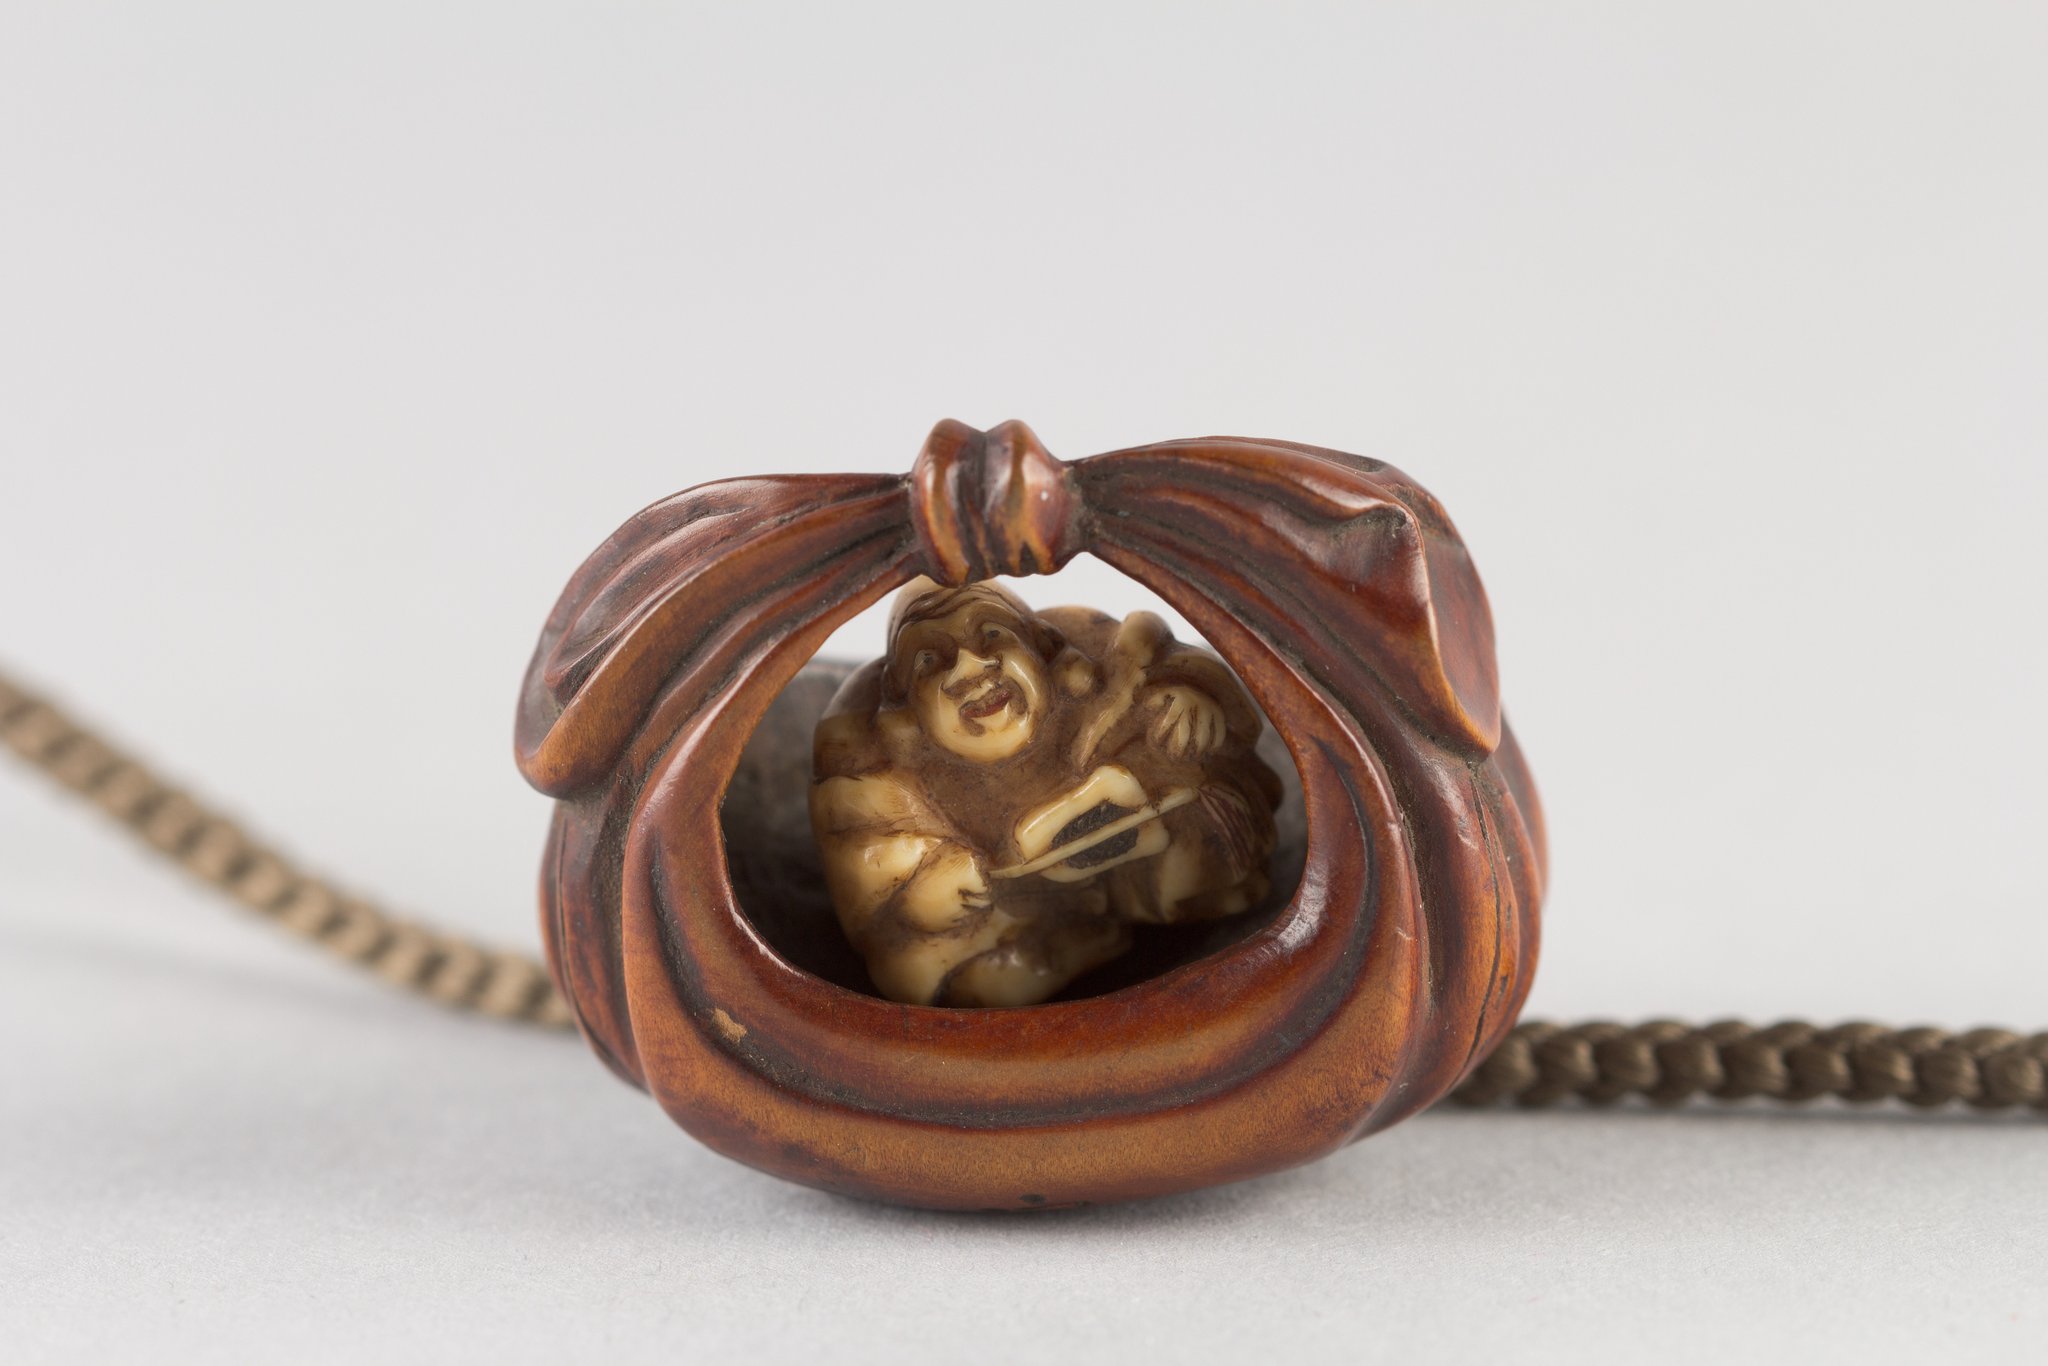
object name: netsuke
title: Netsuke of Bag Containing a Figure of Hotei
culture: japanese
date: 1701-1900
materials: ivory, wood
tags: men